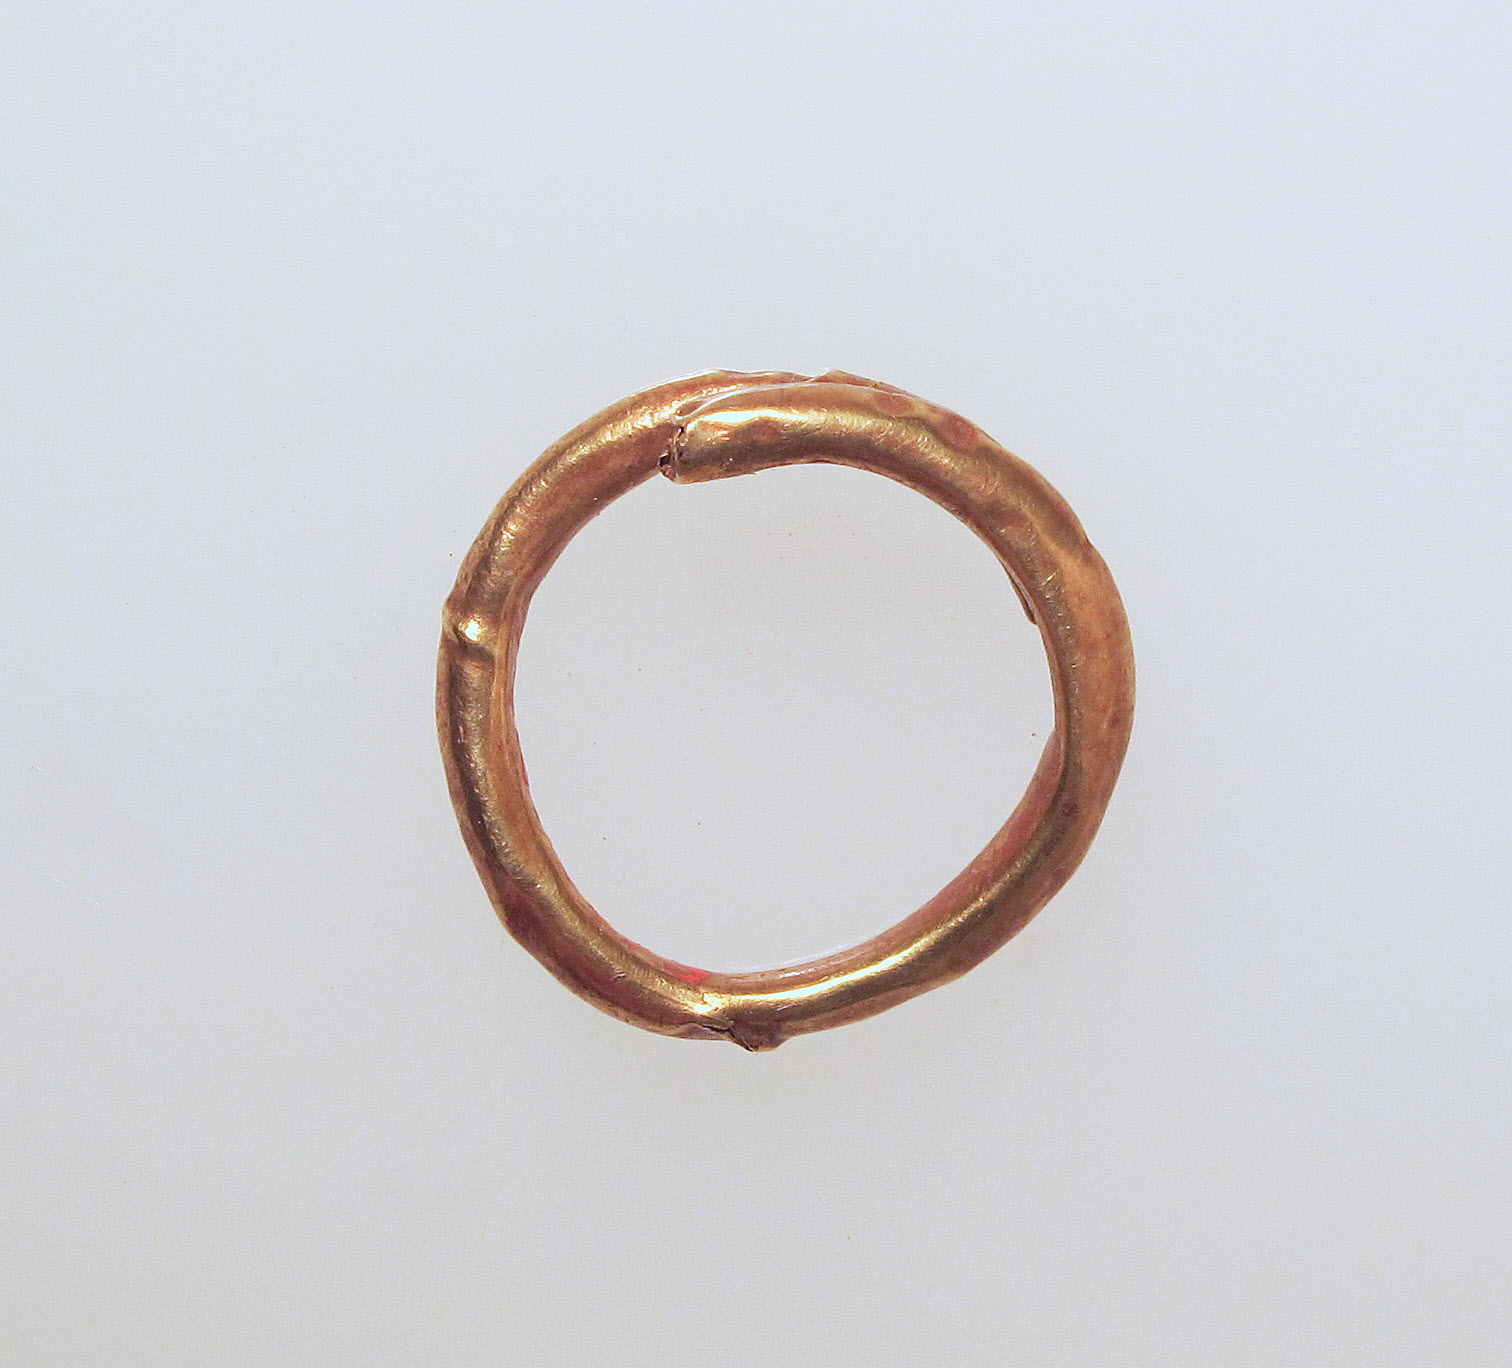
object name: earring or spiral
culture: cypriot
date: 3900 BCE-100 CE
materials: gold